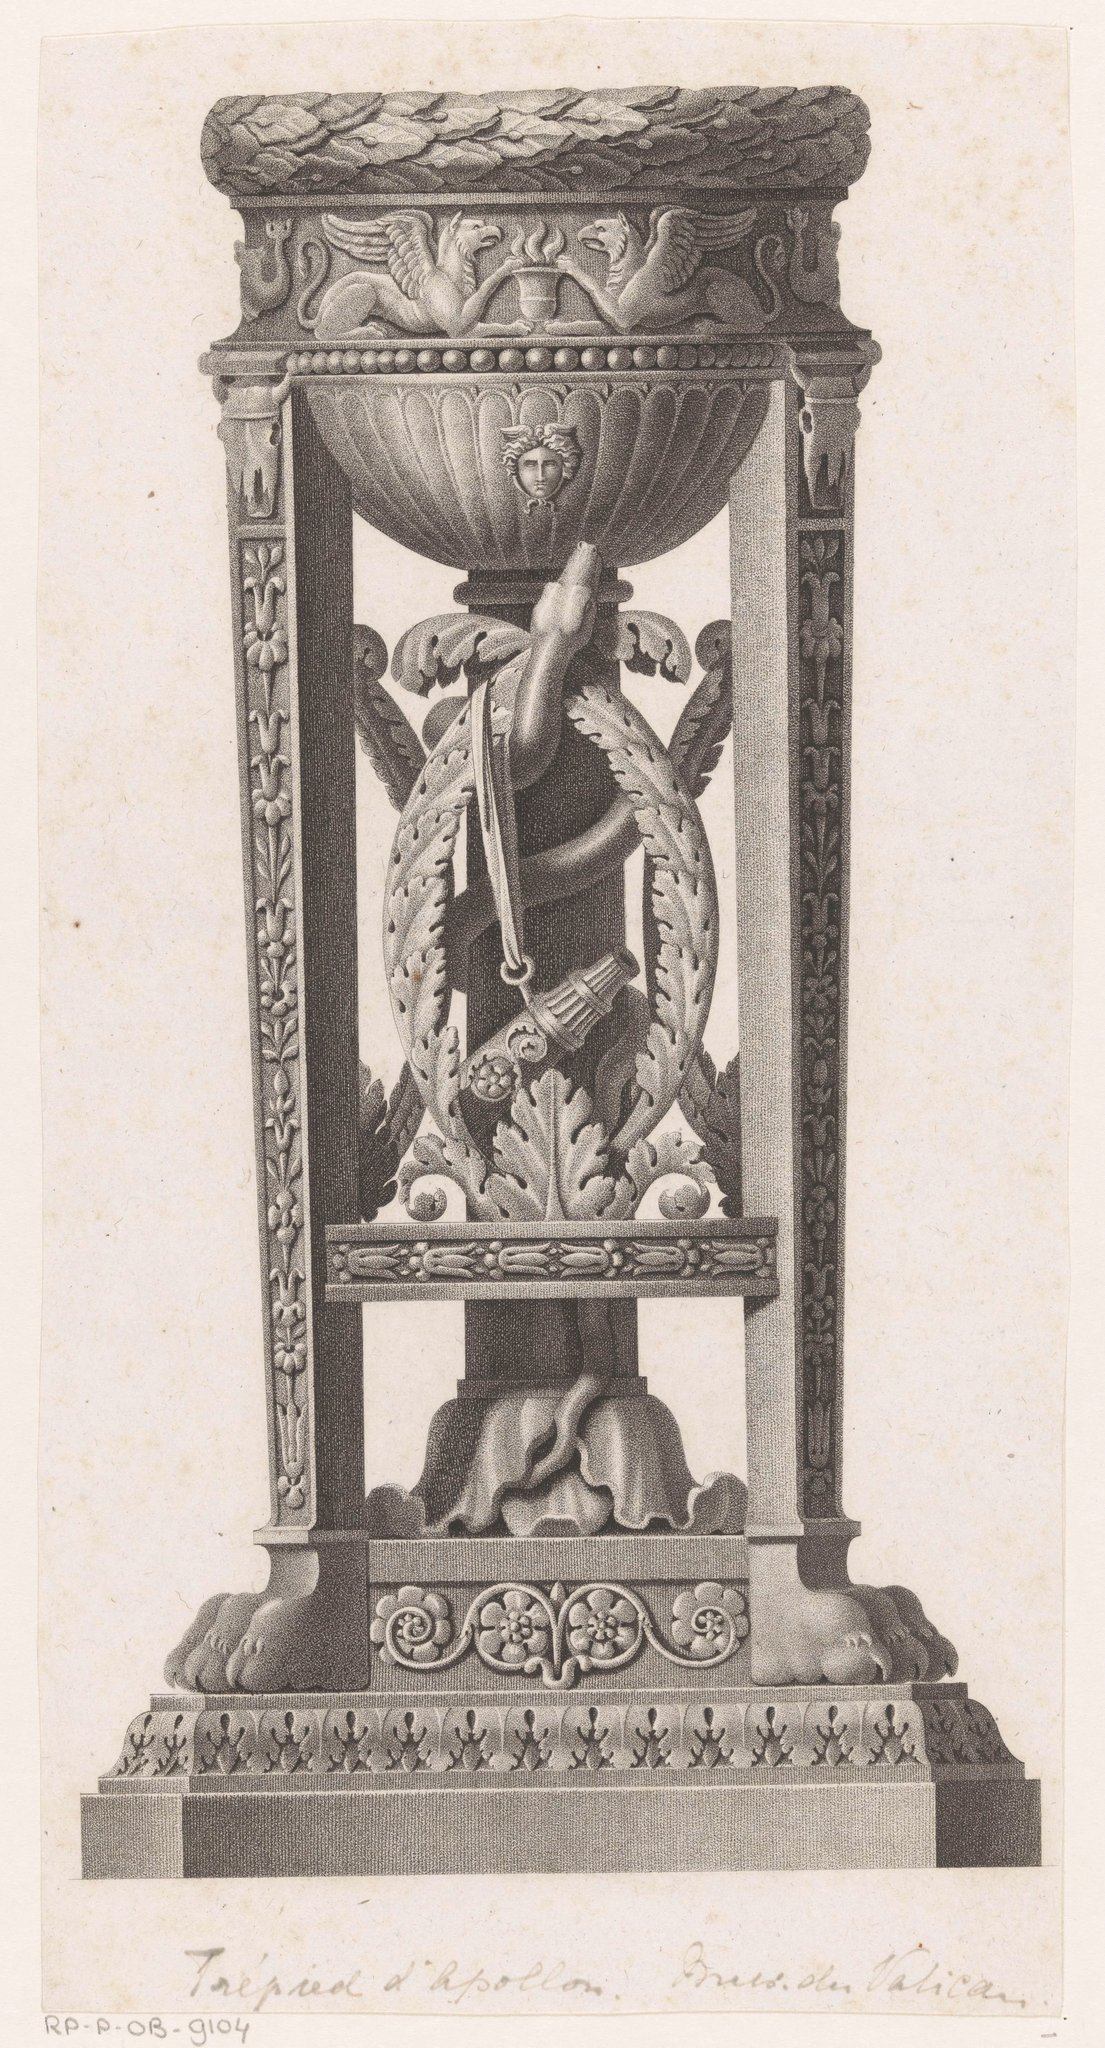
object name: print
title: Fragmens Et Ornemens D'Architecture dessinés A Rome, D'Après L'Antique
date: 1772-1810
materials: paper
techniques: printmaking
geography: france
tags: snakes, griffin (lion/eagle); 'griffo' (ripa), acanthus ~ ornament, the tripod (delphi)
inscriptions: collector's mark: Lugt 2228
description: Ontwerp voor een drievoet van Apollo op leeuwenpoten. Gedecoreerd met bloemmotieven en een fries met griffioenen. De kom rust op een voetstuk gedecoreerd met acanthusbladeren en een slang.